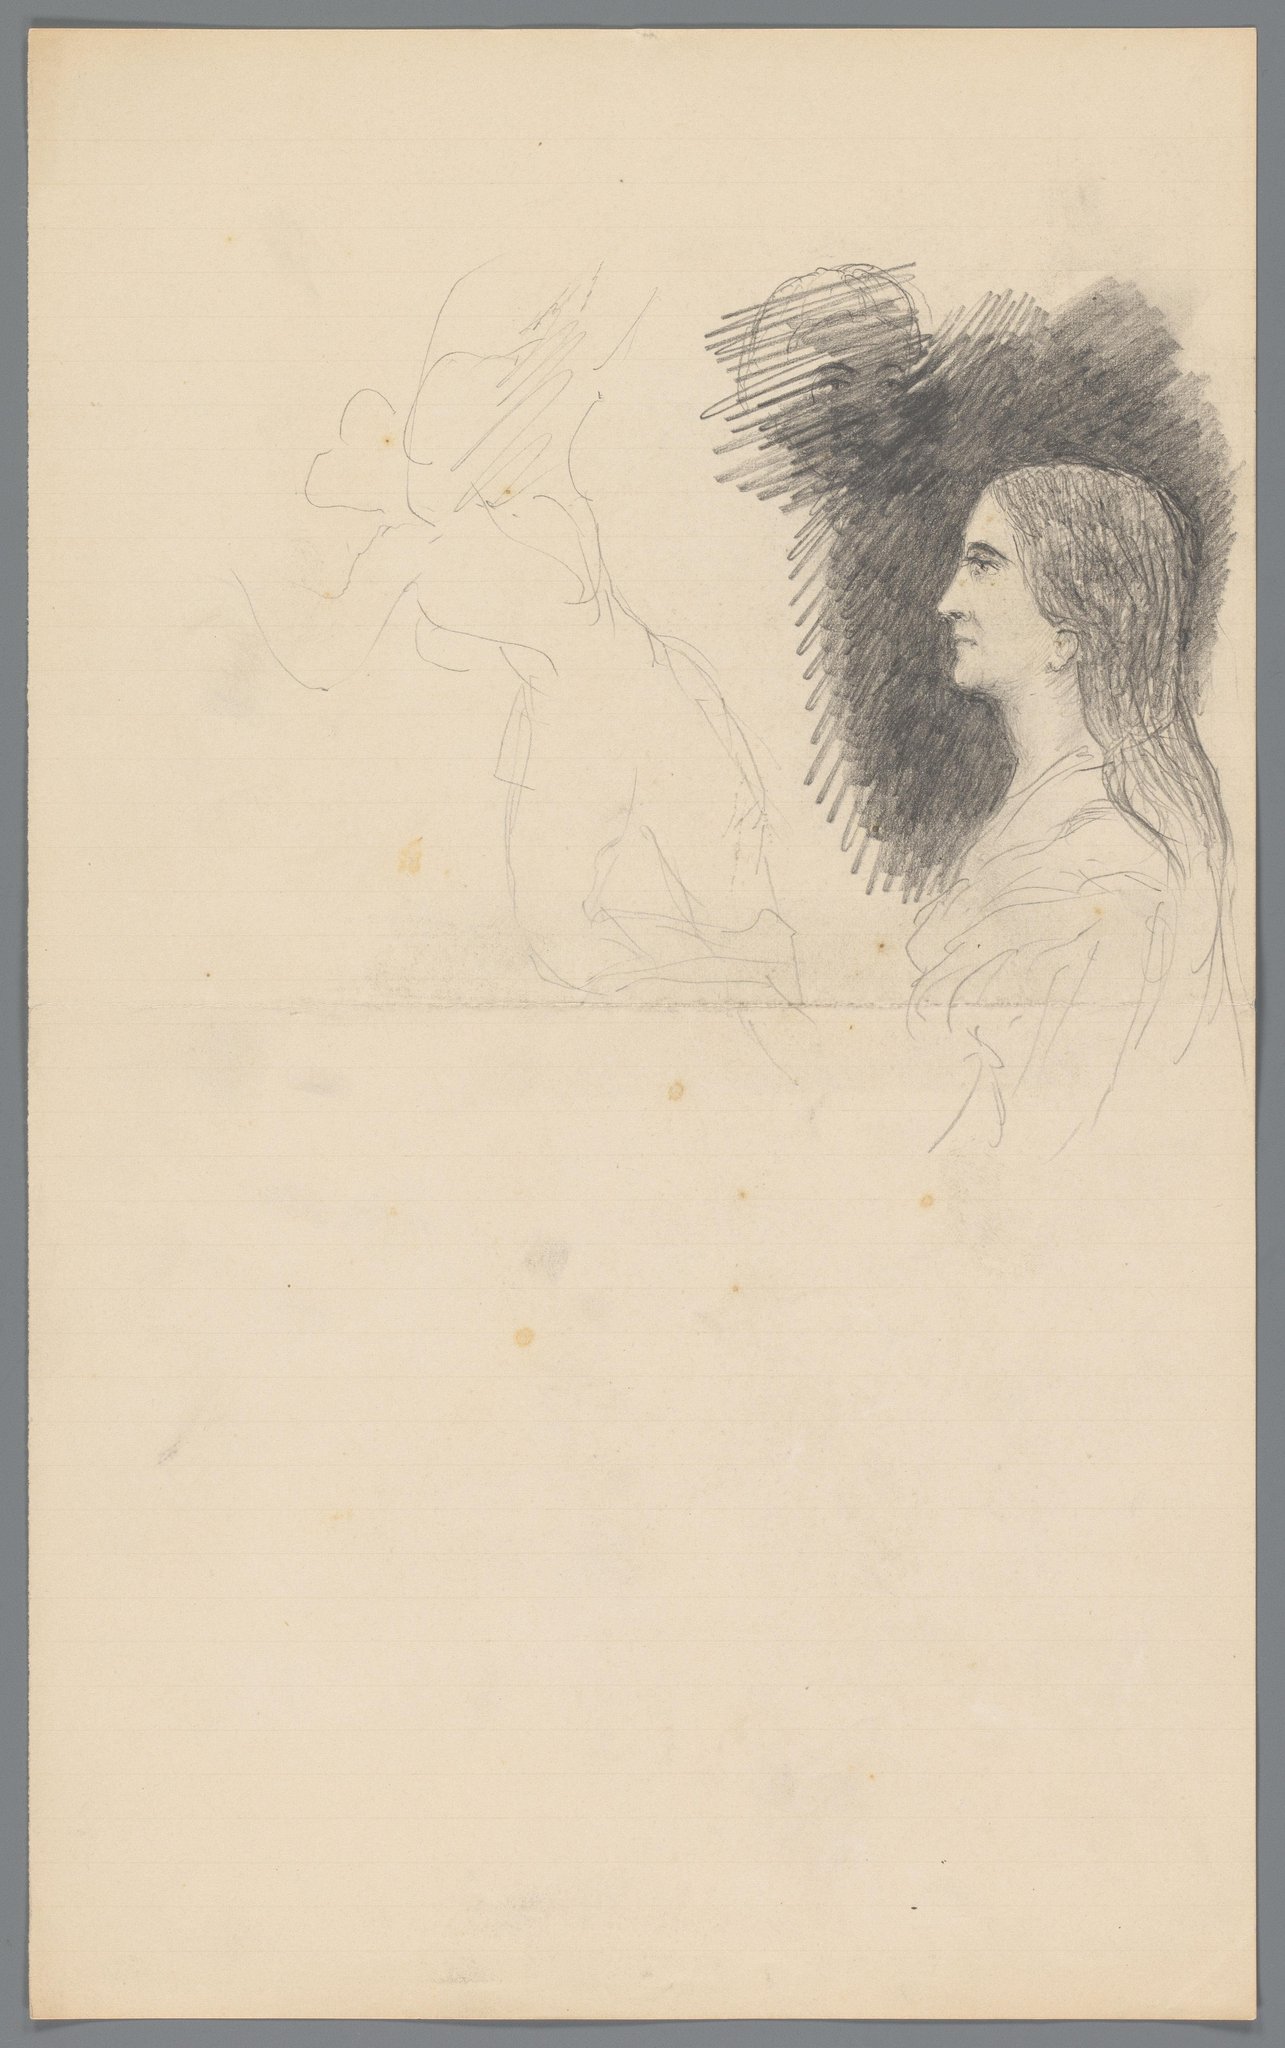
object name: drawing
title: Schetsblad met studie van een engel en een vrouwenportret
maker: august allebé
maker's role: draughtsman, print maker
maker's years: 1838-1927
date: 1848-1927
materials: paper, pencil